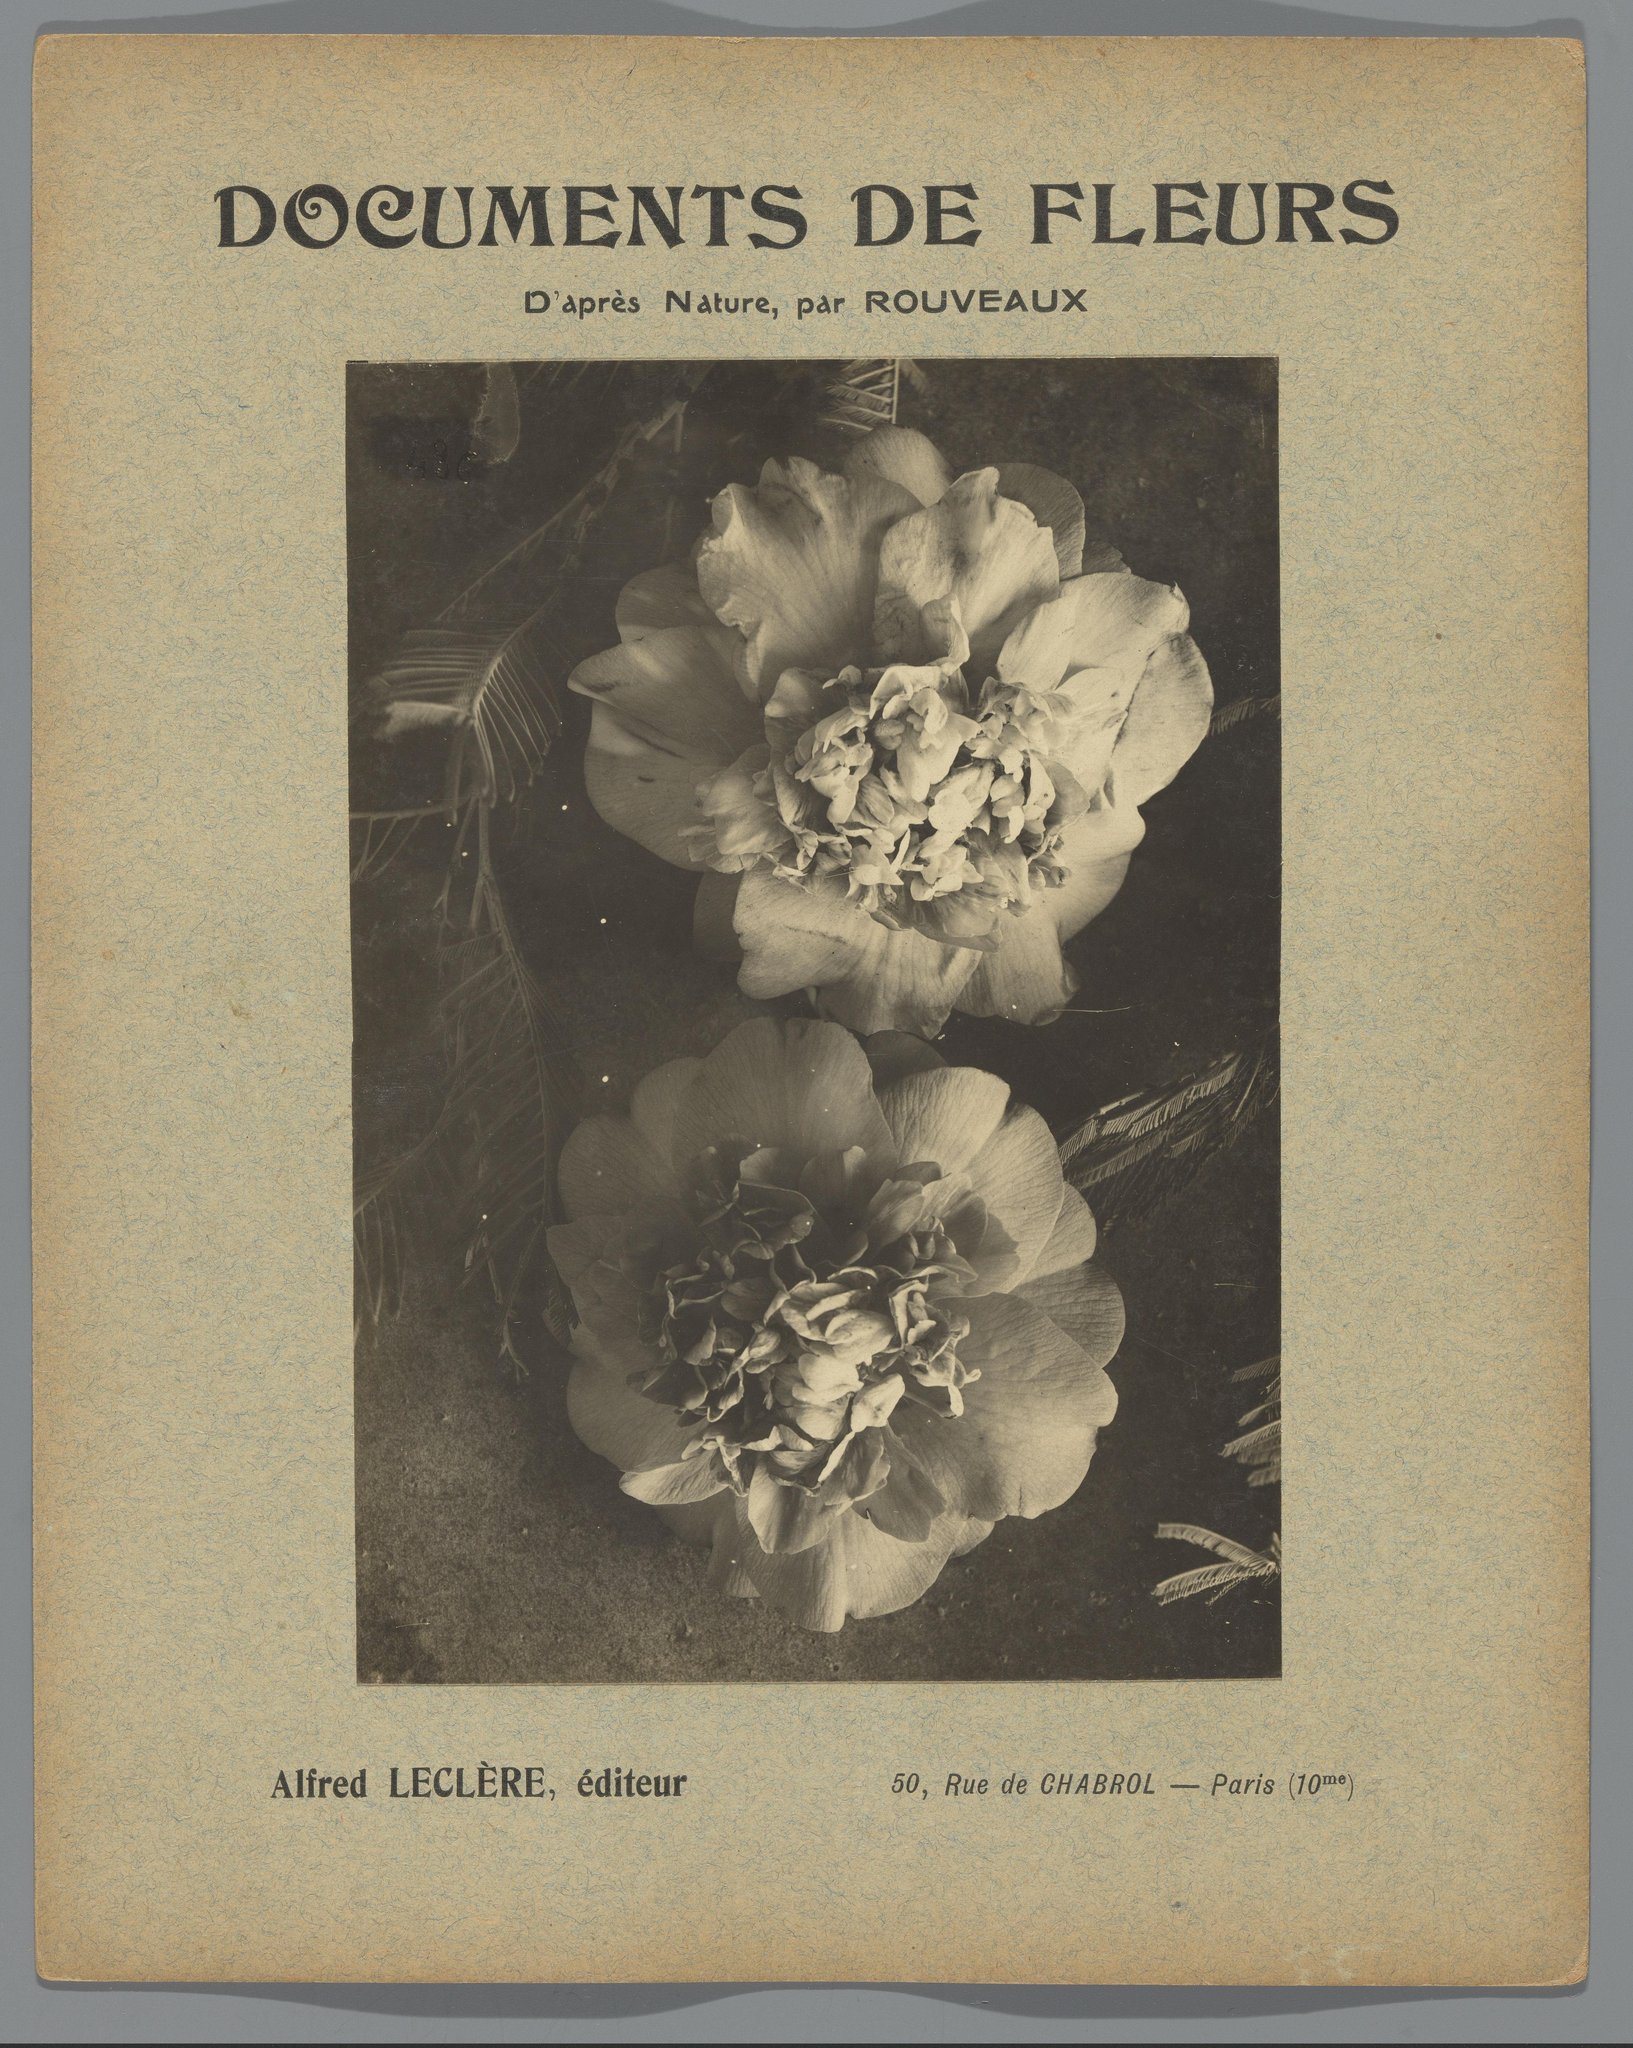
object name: photograph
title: Bloemstudie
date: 1895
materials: photographic support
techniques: gelatin silver print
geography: france